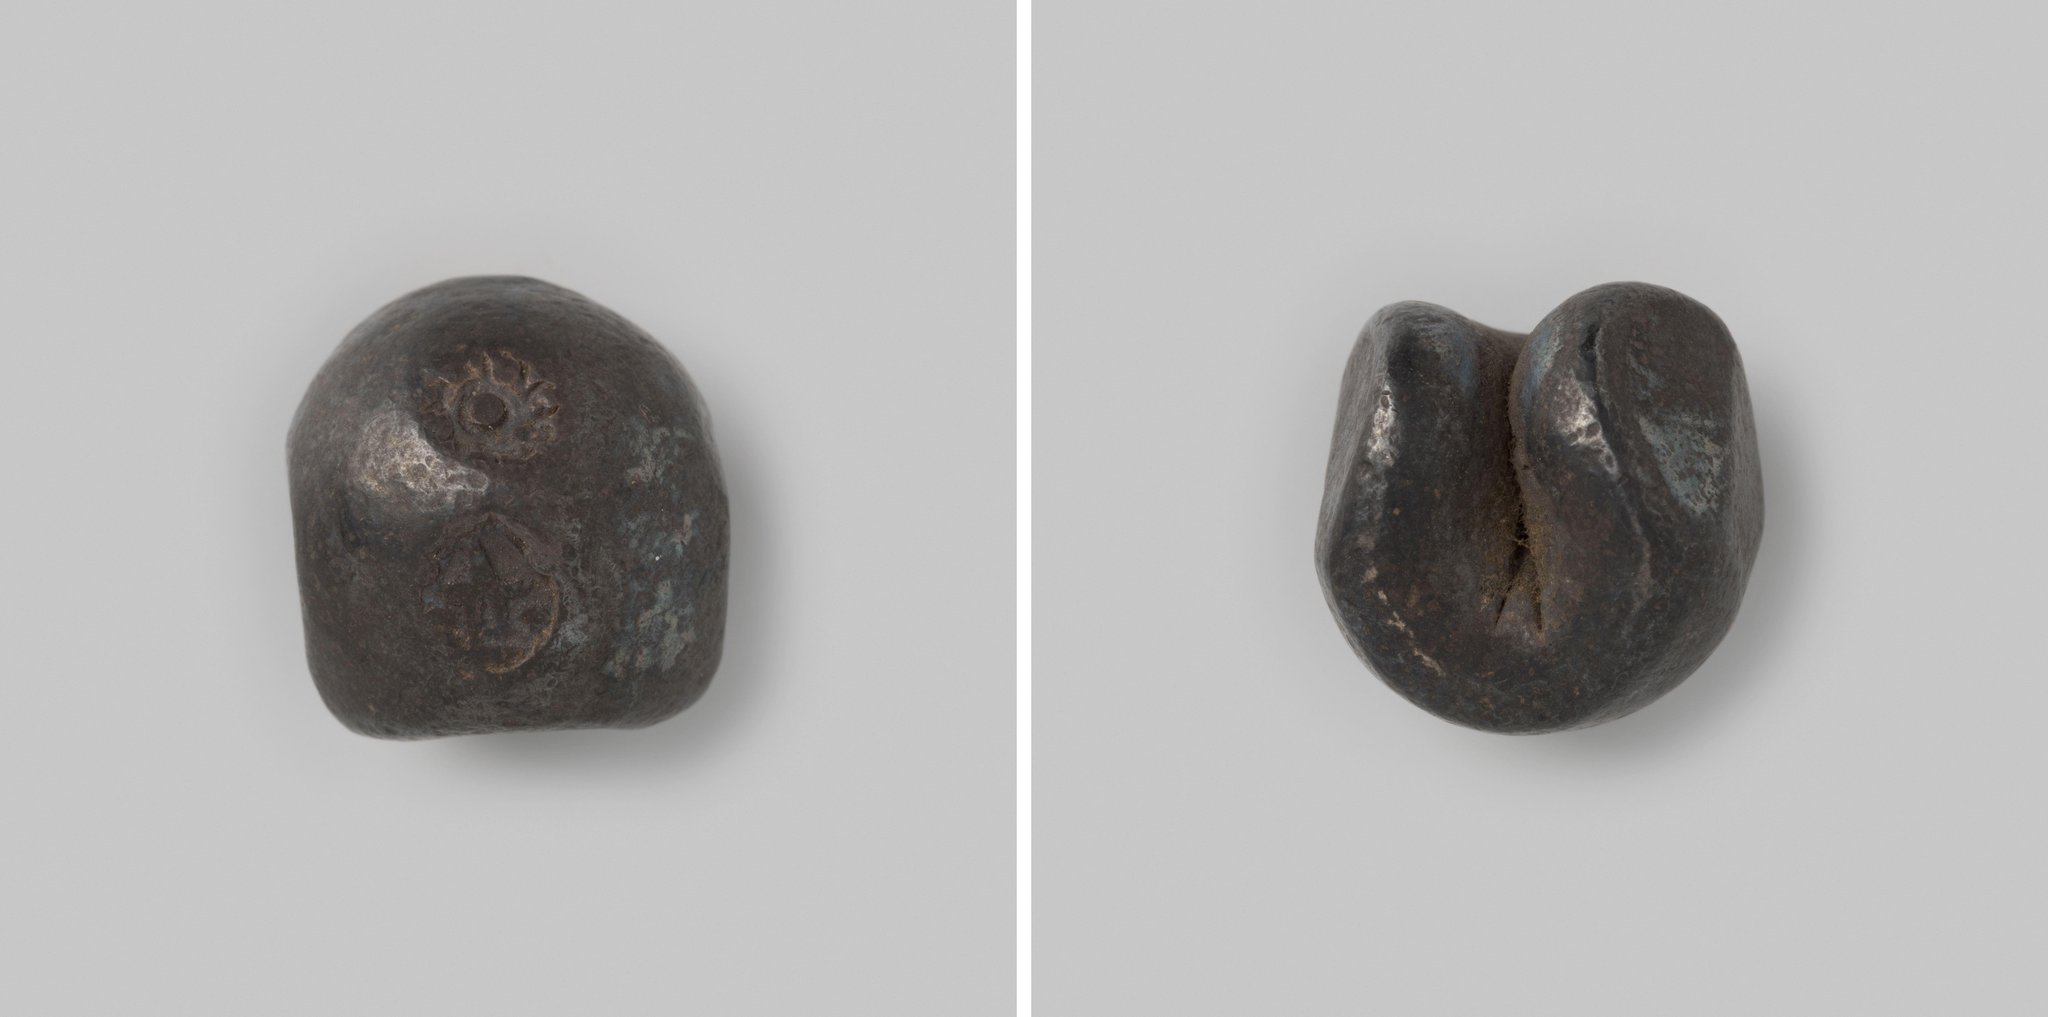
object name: coin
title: Tical uit Thailand van Nang KlaoTsjao,1824-1851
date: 1824-1851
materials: silver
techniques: casting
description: Zilveren, korrelvormige munt. voorzien van twee instempelingen (kra): rozet en boomblad [?].